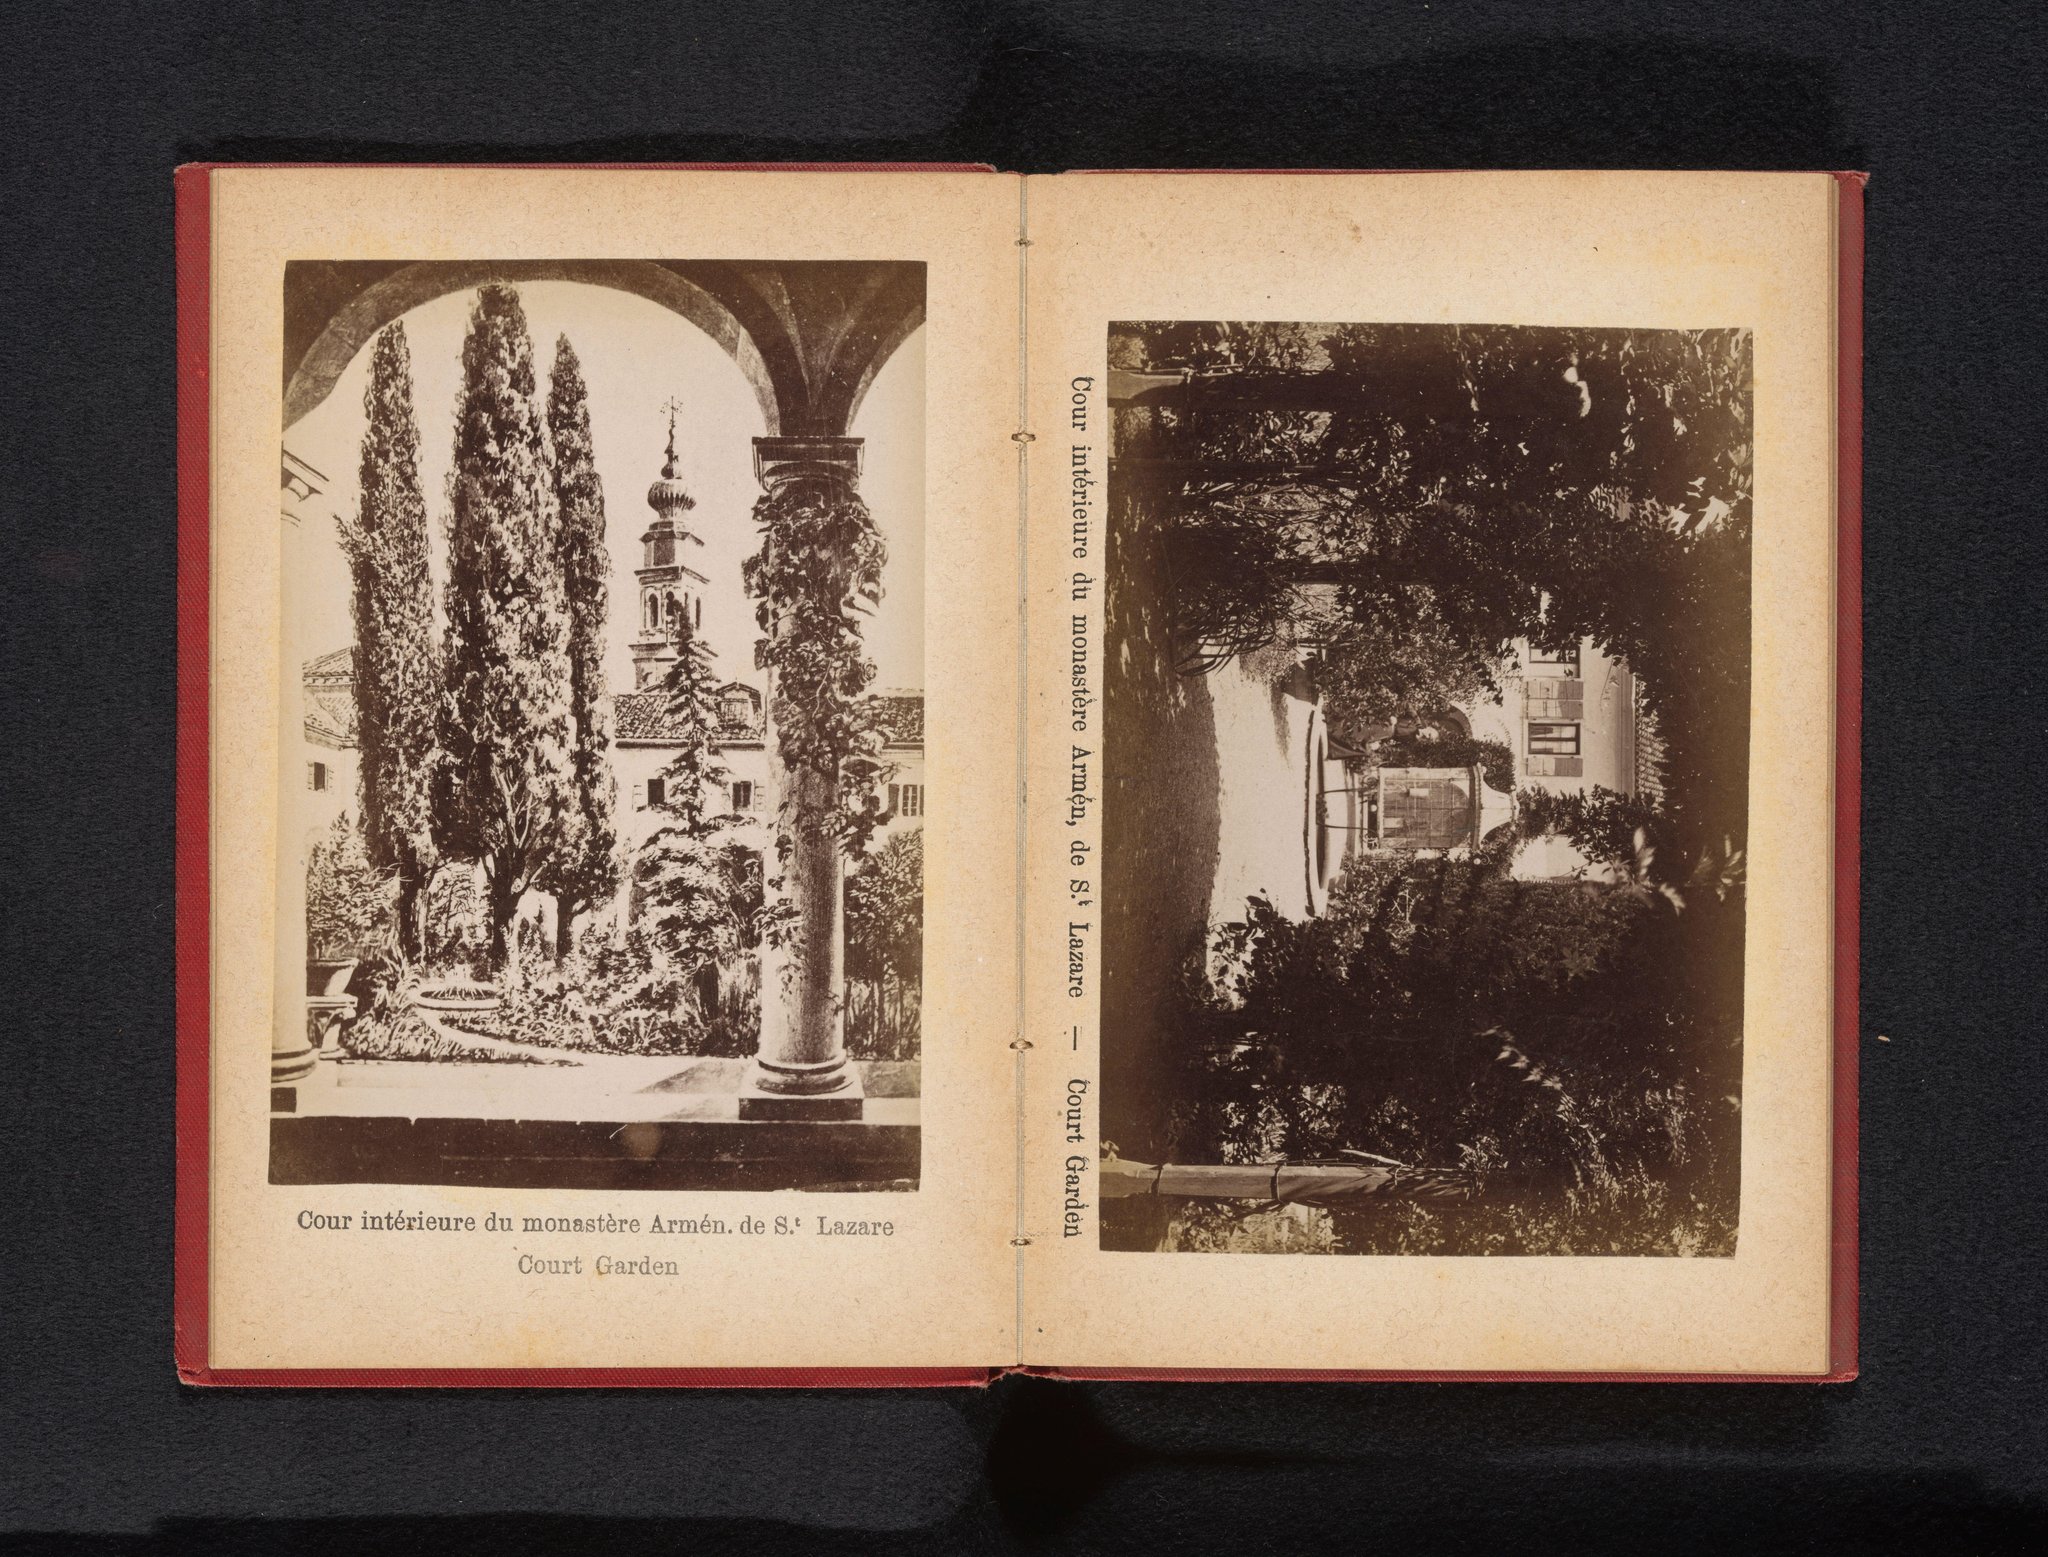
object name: reproduction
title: Court garden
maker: Anonymous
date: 1870-1880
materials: paper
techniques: albumen print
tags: abbey garden